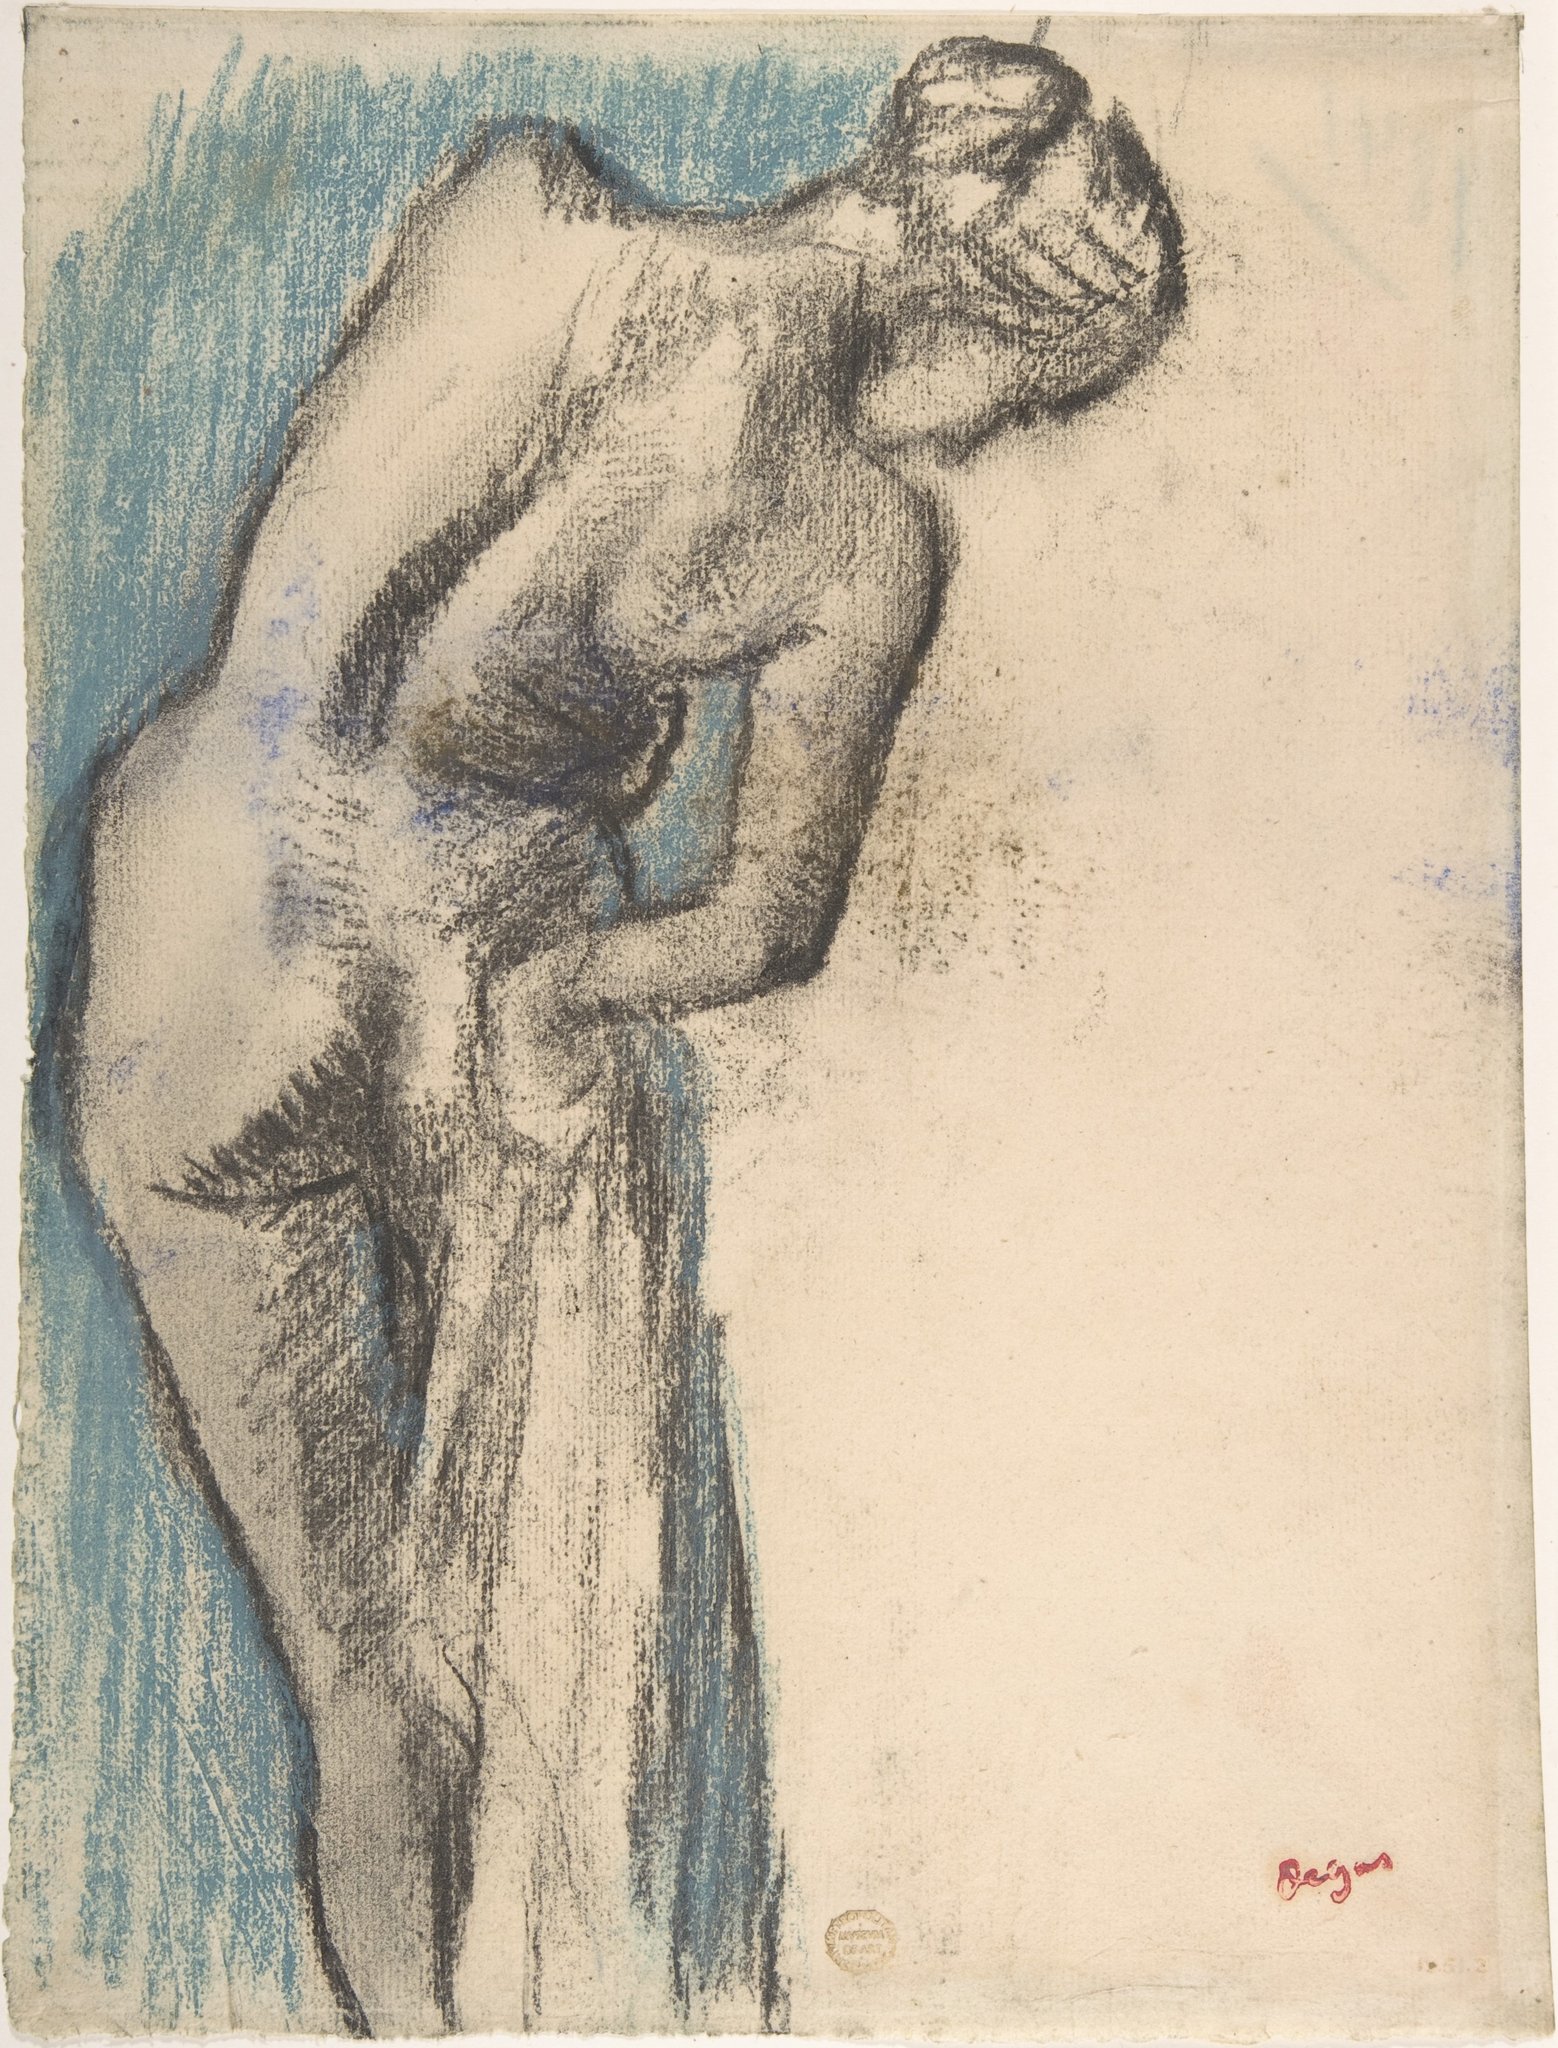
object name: drawing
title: Bather Drying Herself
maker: edgar degas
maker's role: artist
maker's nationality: french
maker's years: 1834-1917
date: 1883-1884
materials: charcoal, paper, pastel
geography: france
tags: female nudes,bathing